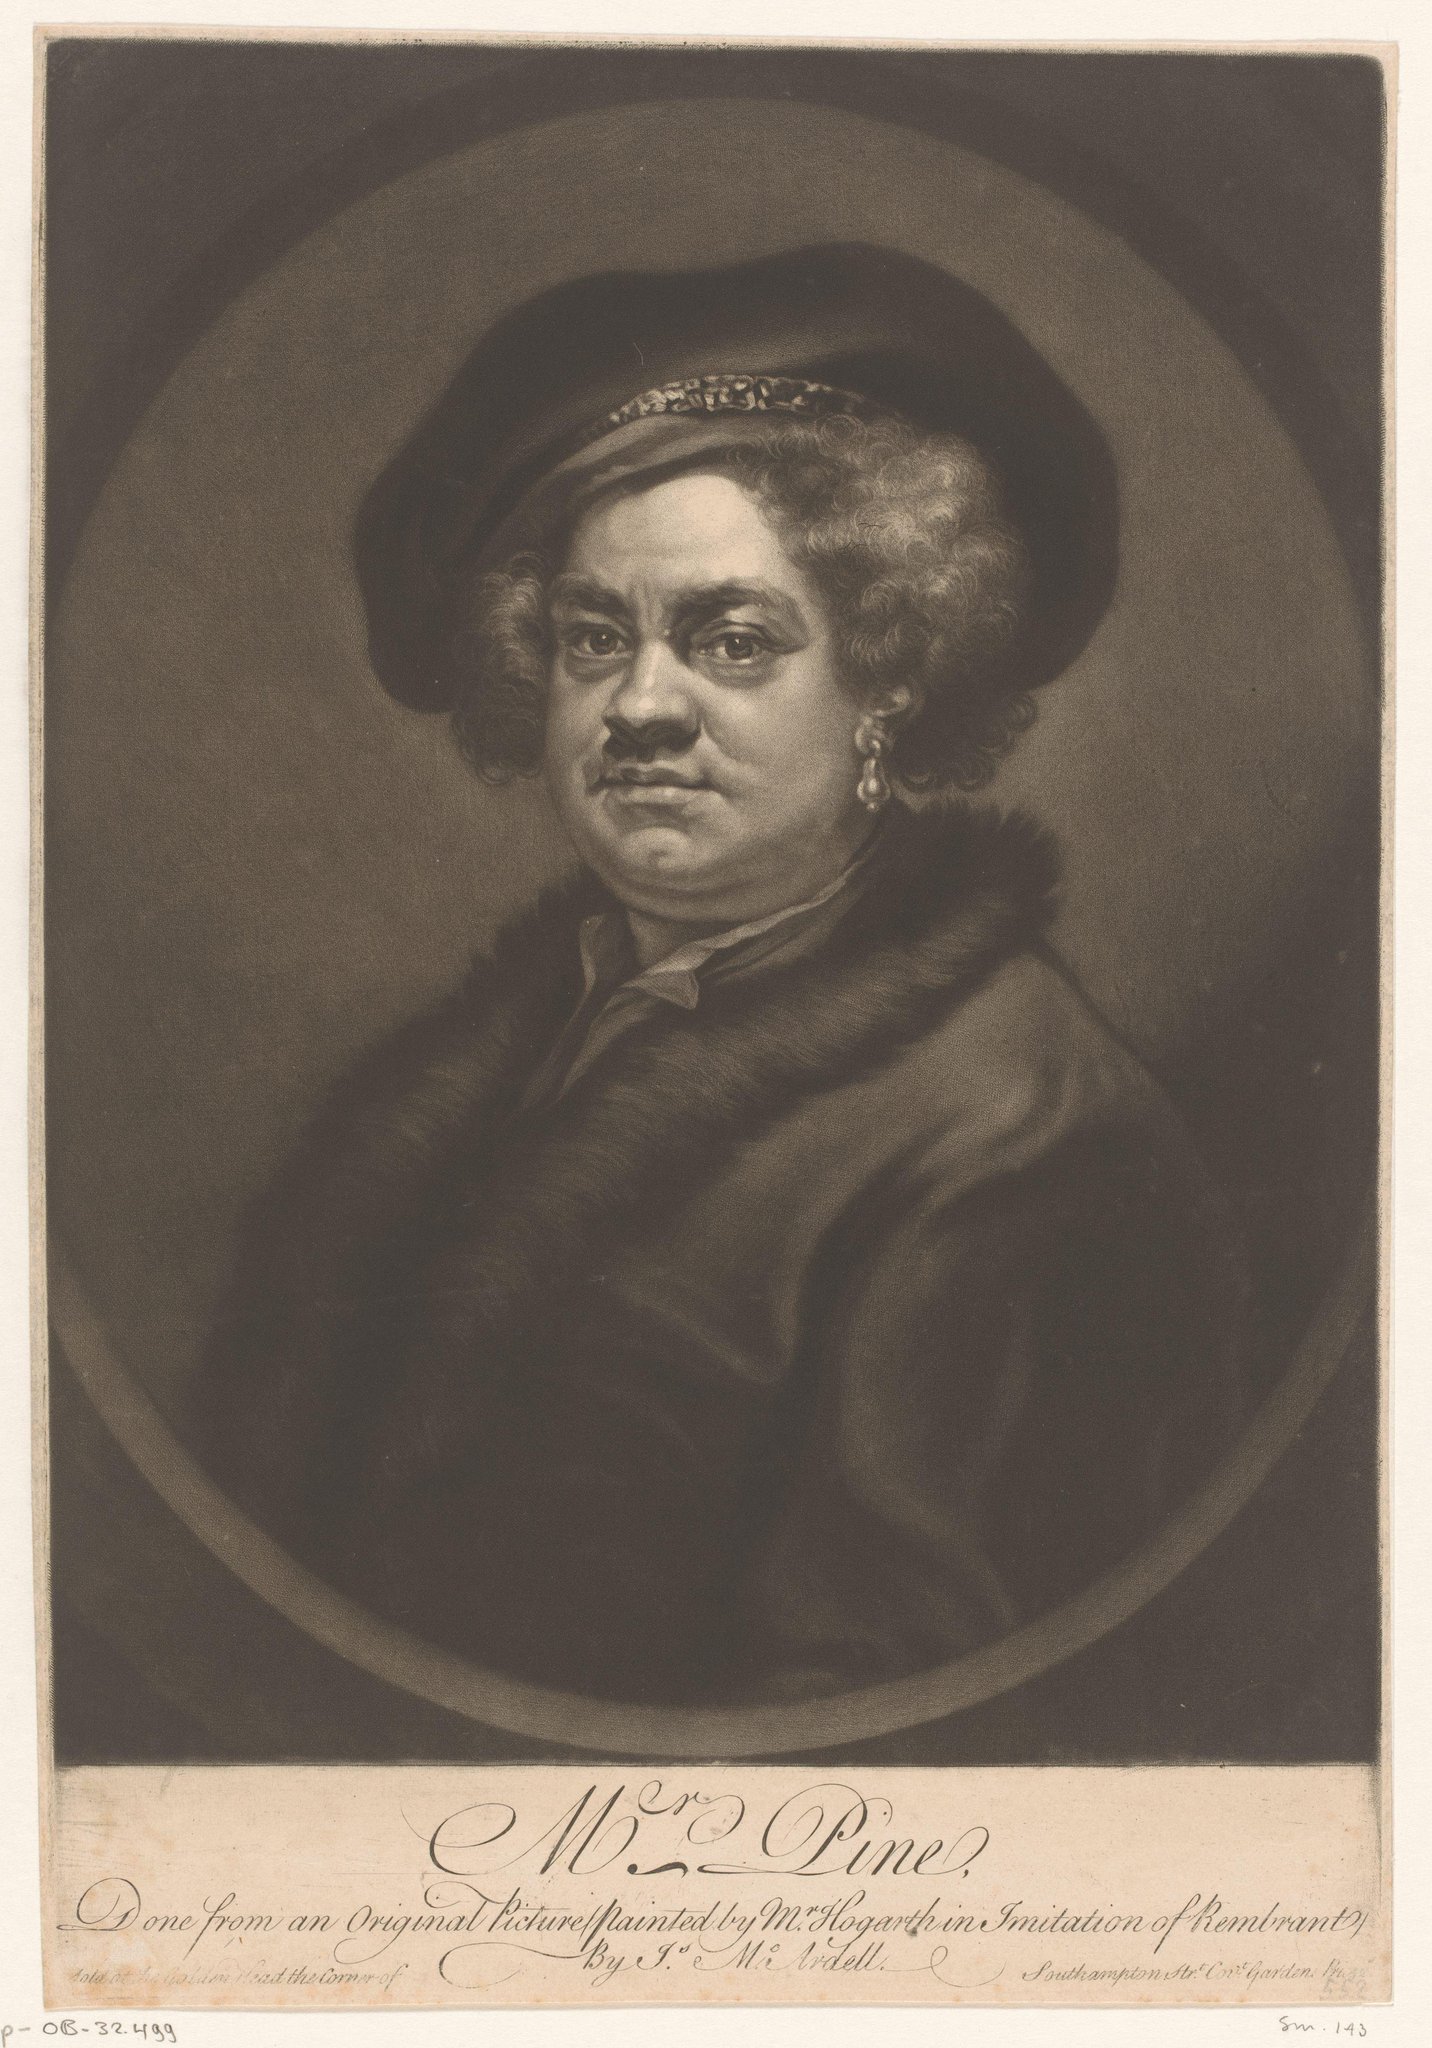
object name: print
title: Portret van John Pine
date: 1755-1765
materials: paper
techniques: mezzotint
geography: london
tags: london, print maker, publisher, john pine, historical persons, portrait, self-portrait of graphic artist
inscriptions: collector's mark: Lugt 240